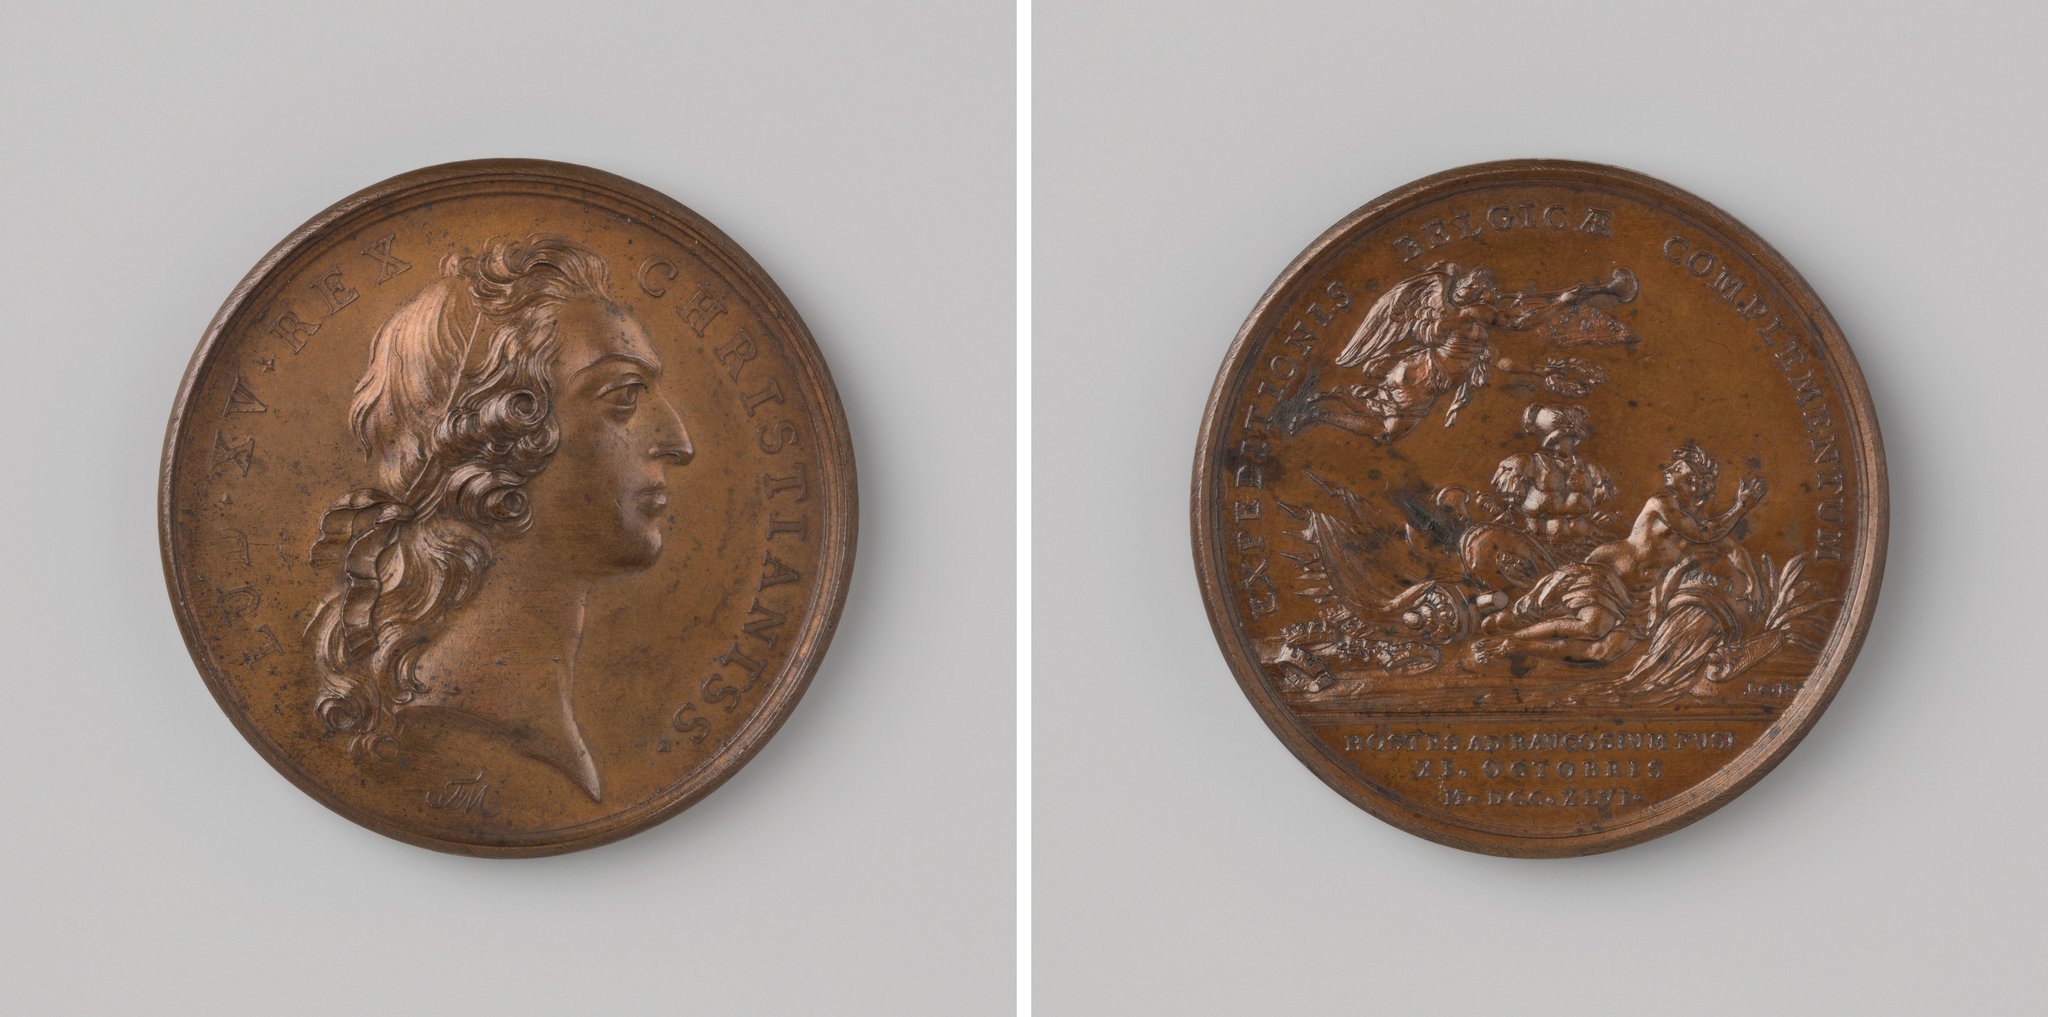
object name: history medal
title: Slag bij Rocourt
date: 1746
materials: bronze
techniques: striking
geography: paris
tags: louis xv of france, liège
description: Bronzen penning. Voorzijde: borststuk man binnen omschrift. Keerzijde: riviergodin, rustend op waterkruik voor trophee bestaande uit wapentuig, vaandels en harnas kijkt verschrift op naar vliegende Faam, die op bazuin blaast, waaraan lelievaandel hangt en lauwerkrans boven trophee houdt binnen omschrift; afsnede: opschrift